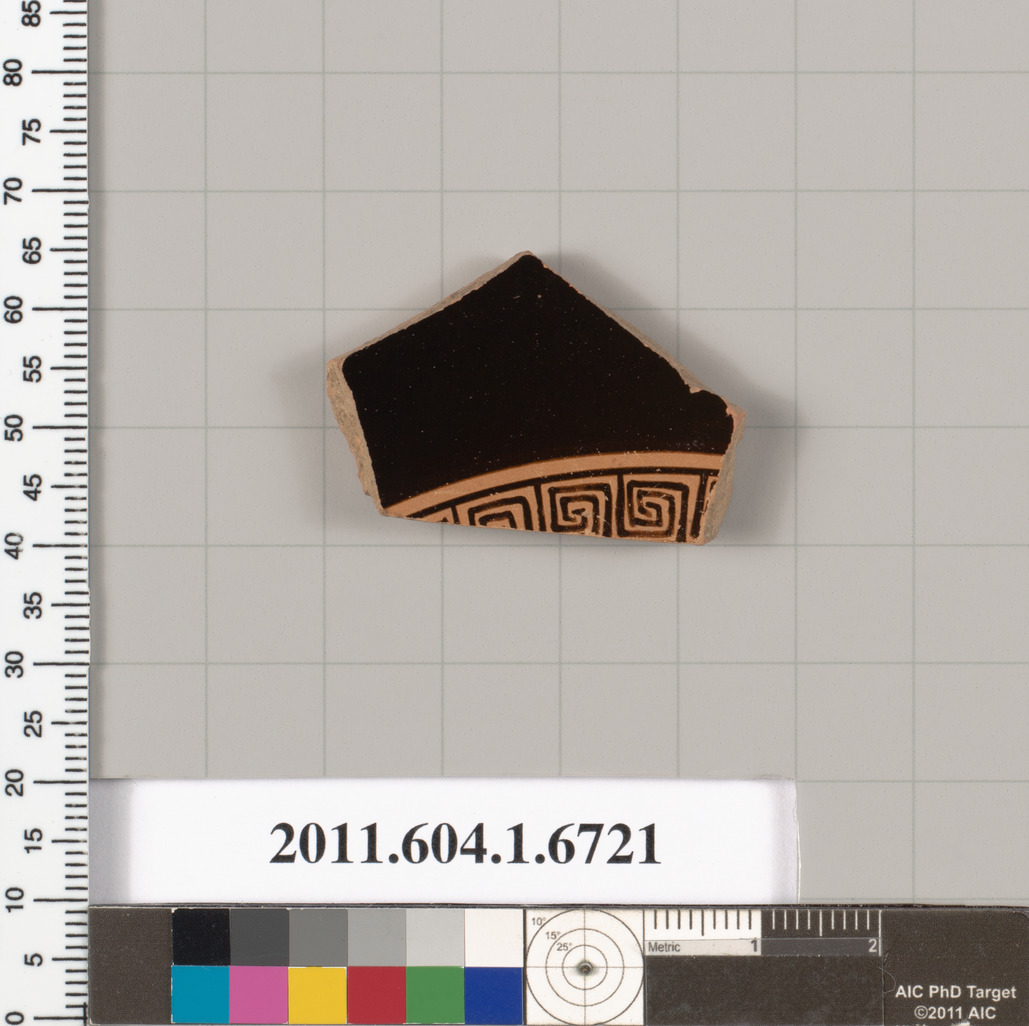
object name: kylix fragment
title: Terracotta fragment of a kylix (drinking cup)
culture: greek, attic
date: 490-470 BCE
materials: terracotta